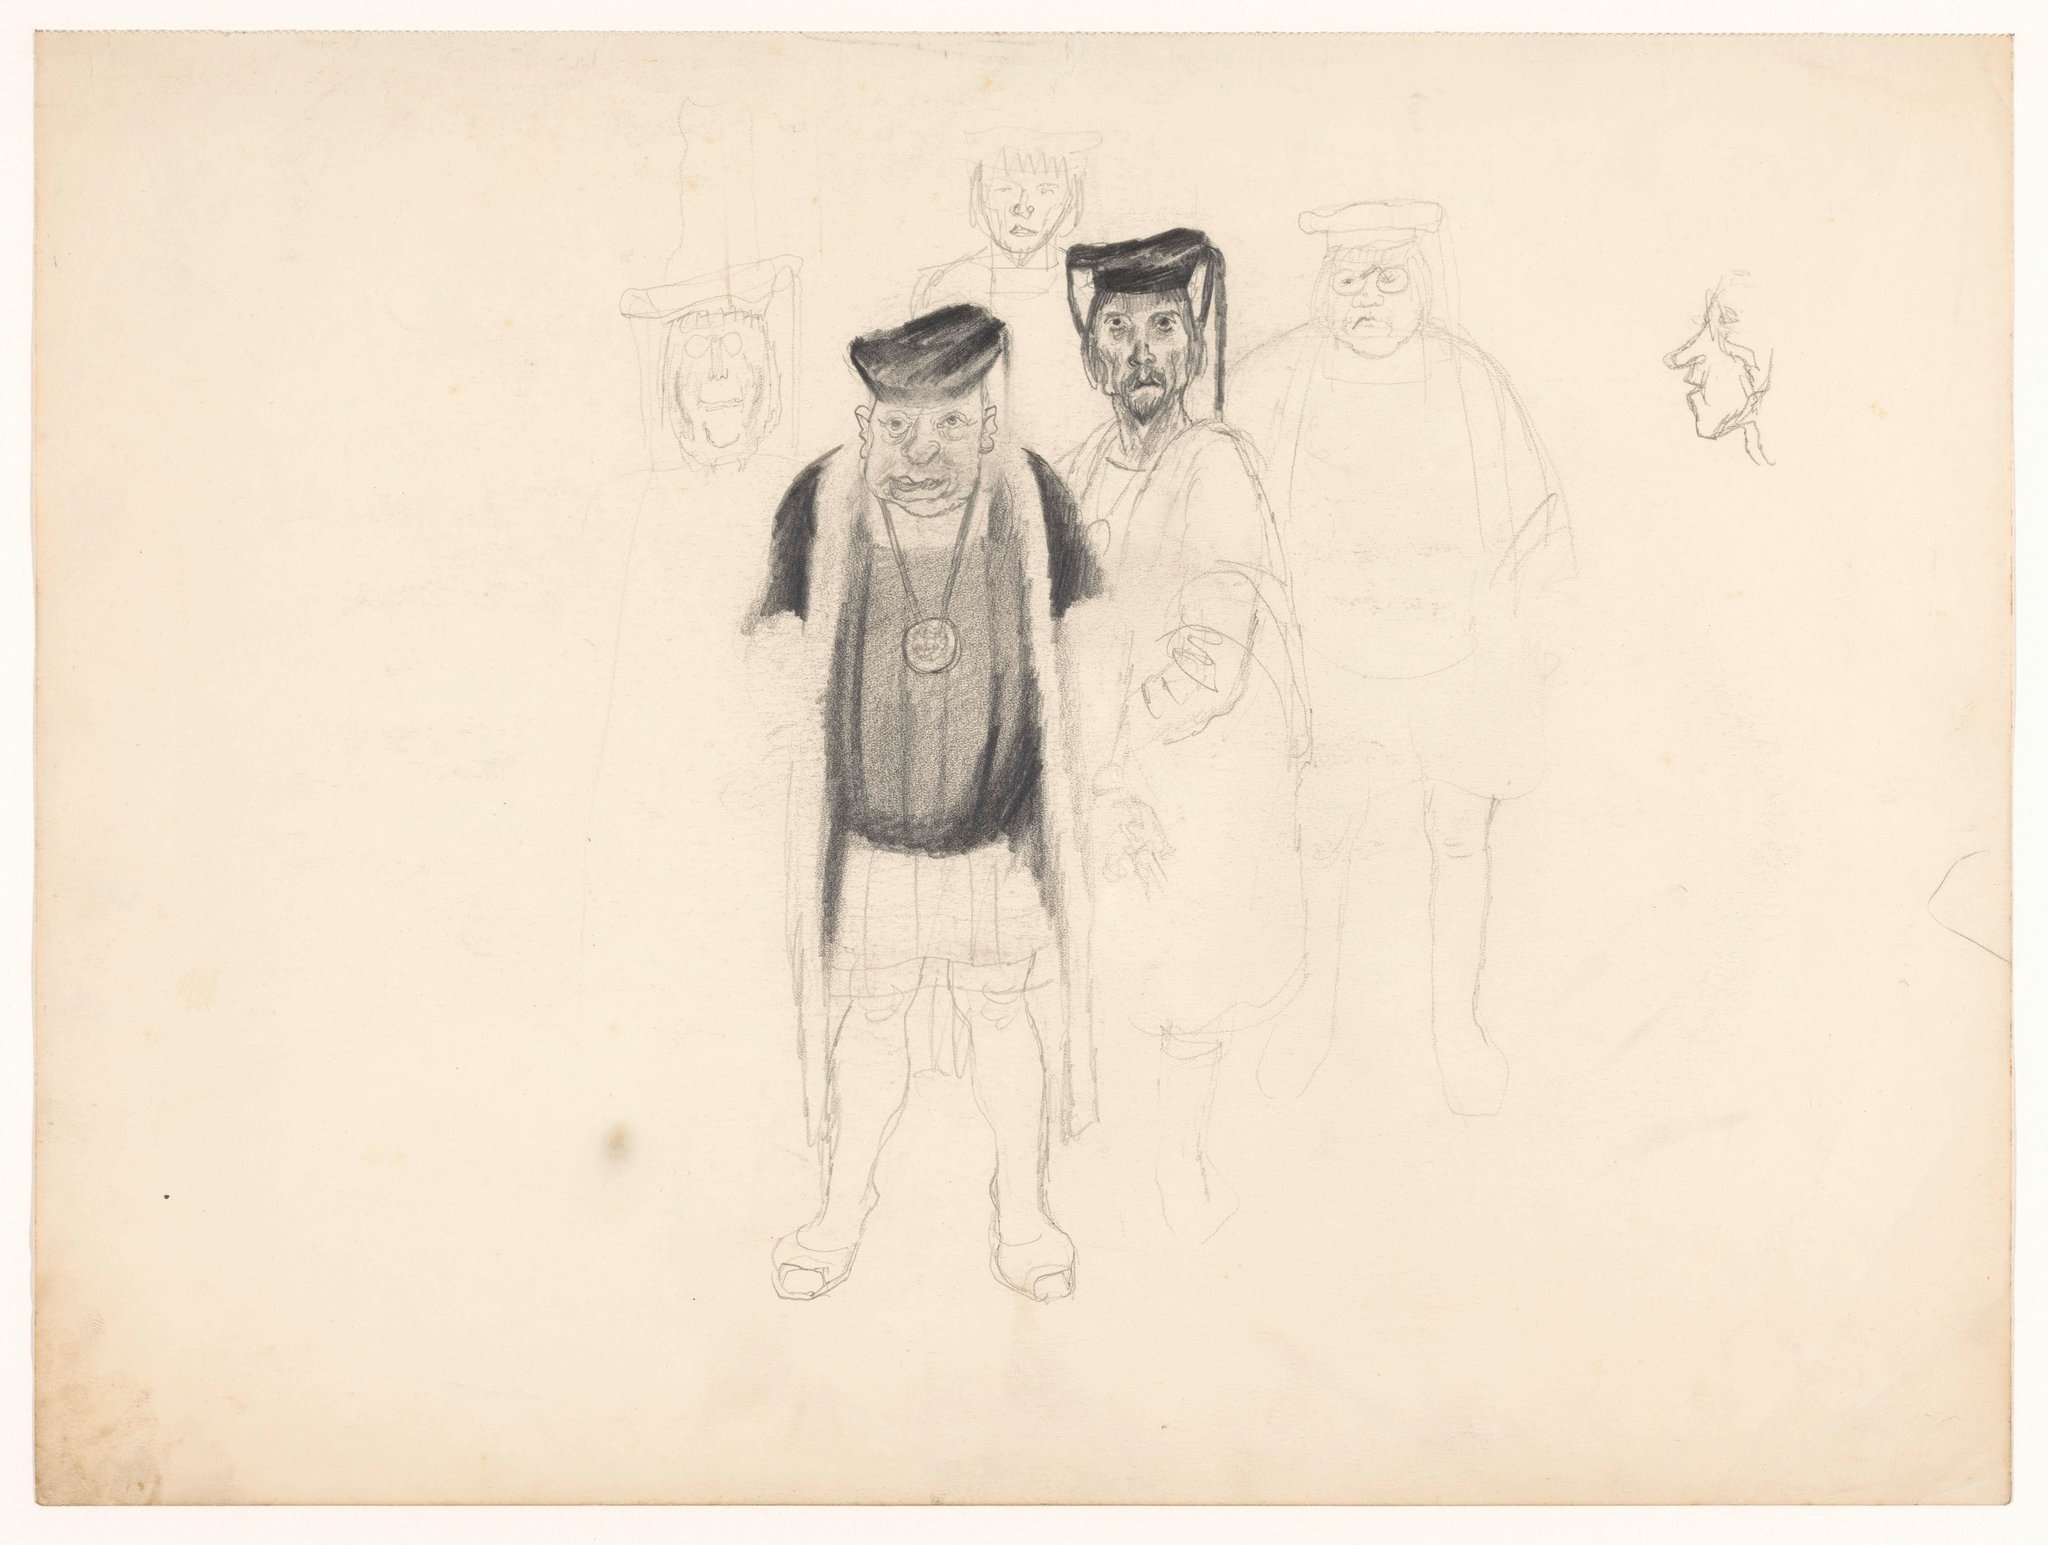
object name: drawing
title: Groep staande figuren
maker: henk henriët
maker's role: draughtsman, print maker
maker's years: 1903-1945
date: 1936-1940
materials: paper, pencil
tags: standing figure, caricatures (human types)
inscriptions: collector's mark: Lugt 2228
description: Deze tekening is mogelijk een ontwerp voor een illustratie bij het boek 'Gargantua en Pantagruel' van François Rabelais.